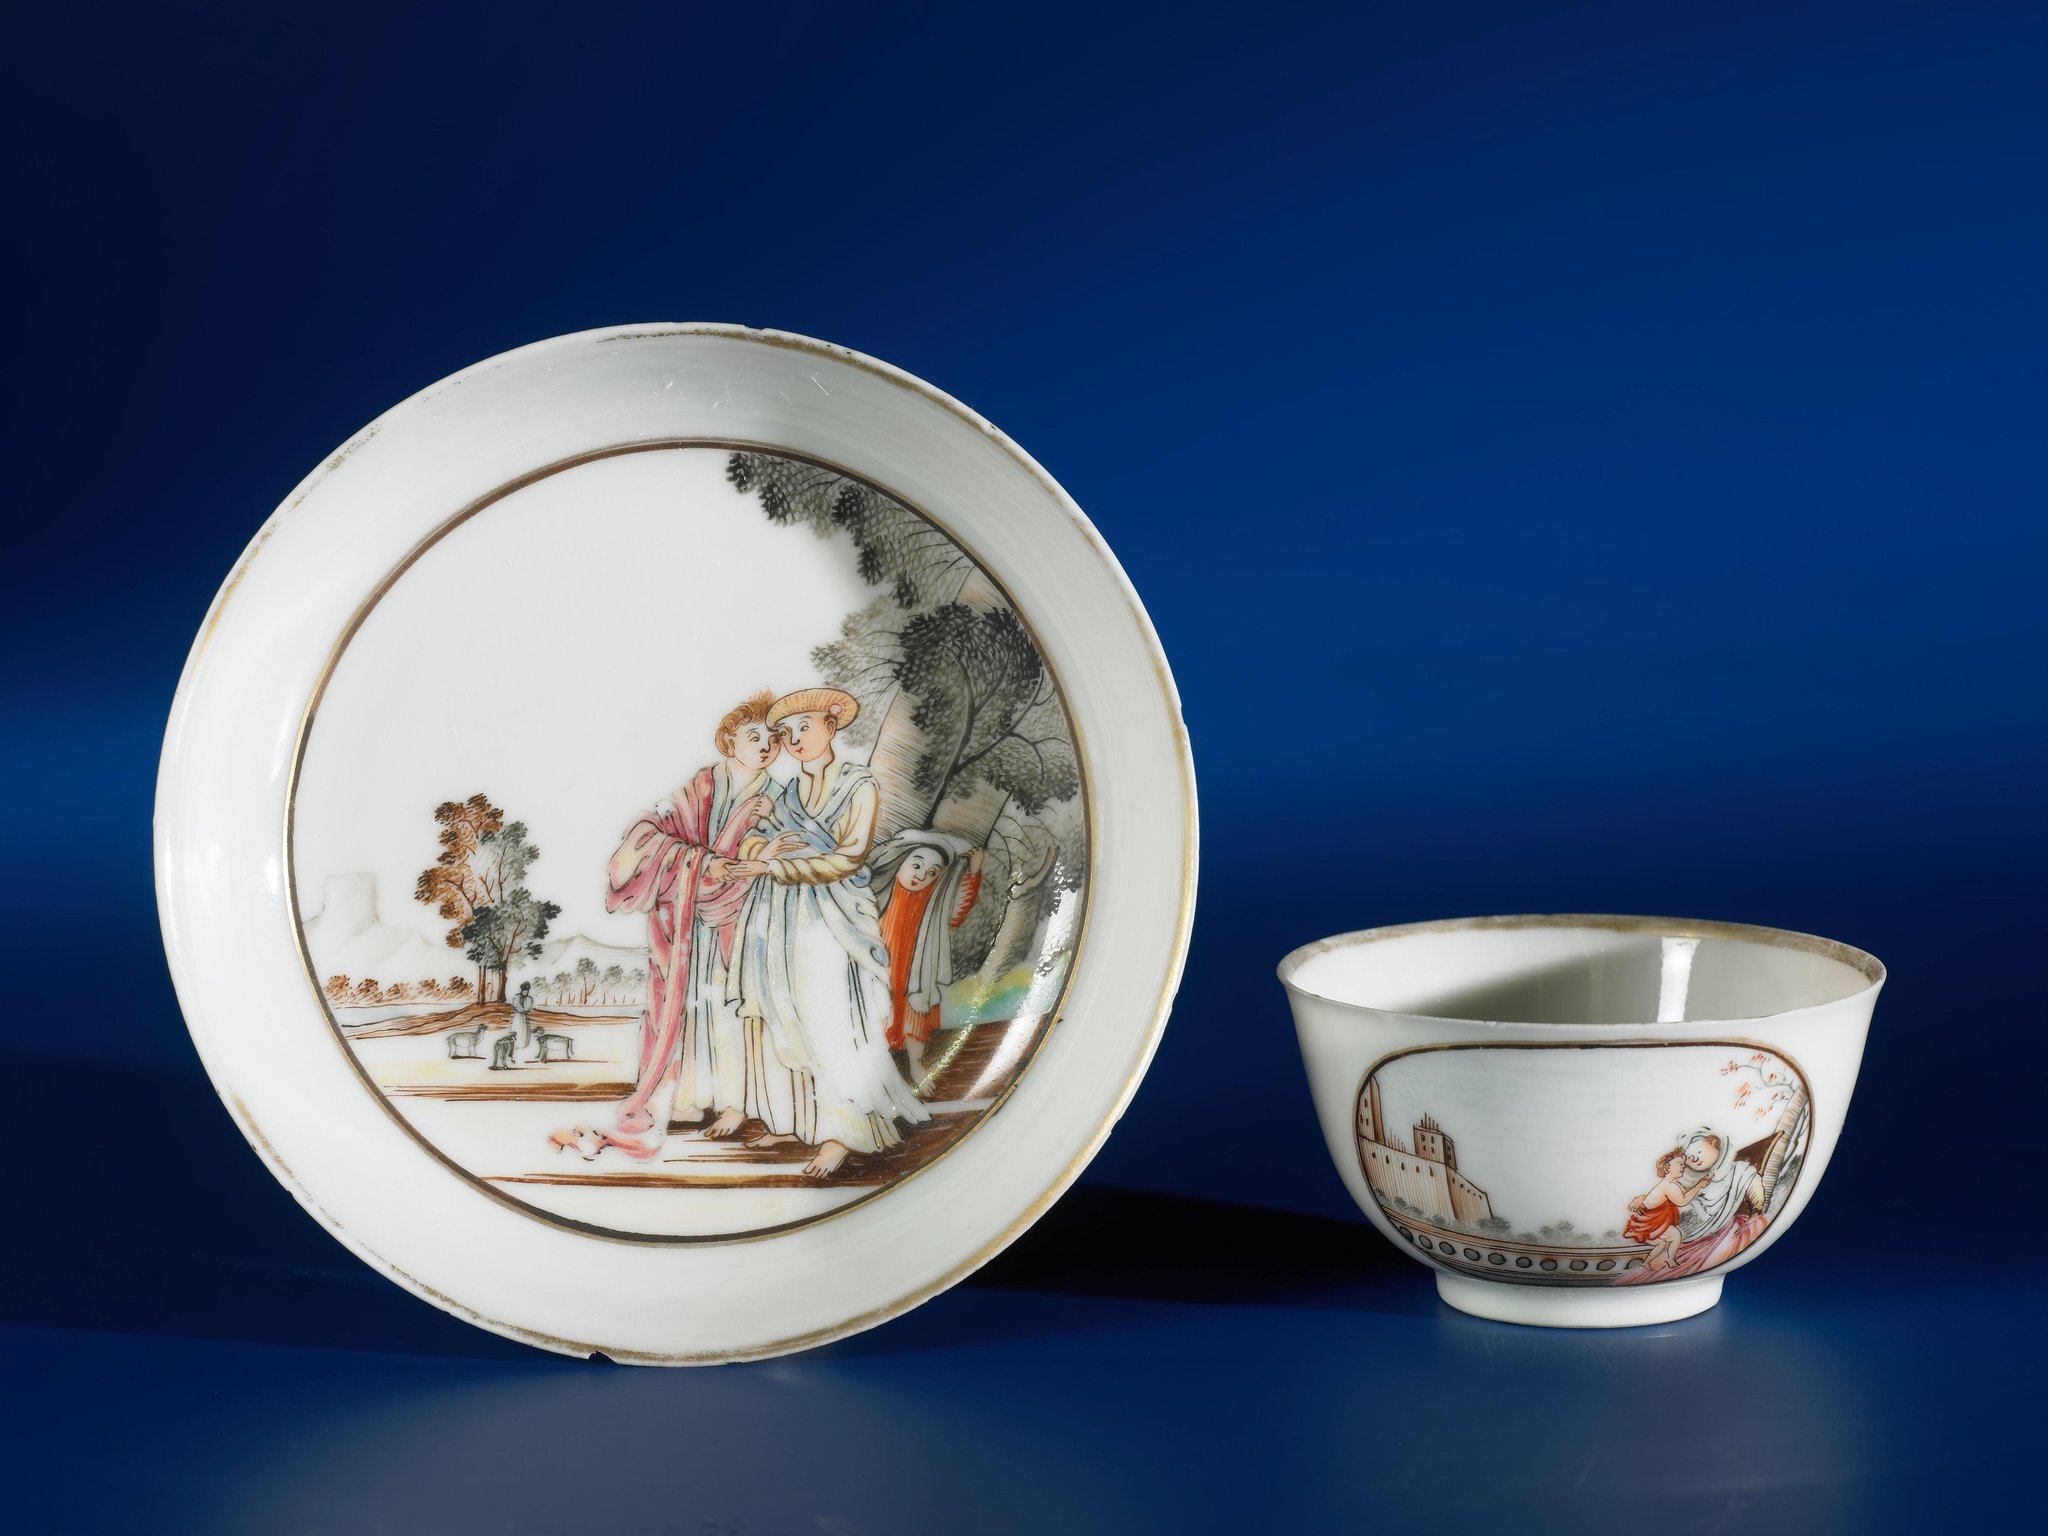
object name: kop en schotel, kop en schotel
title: Bell-shaped cup with European figures in a landscape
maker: Anonymous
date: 1740-1760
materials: glaze, gold, paint, porcelain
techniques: firing, gilding, turning, vitrification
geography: china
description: Wijd uitlopende kop op een hoge voetring en schotel op een voetring. Gedecoreerd in emailkleuren en goud. Op het bord een voorstelling van een verliefd paar in een landschap, gadegeslagen door een derde figuurtje. Op de achtergrond drie schapen en een herder. Op het kopje een voorstelling van een vrouw, zij houdt een kind vast. Op de achtergrond een kasteel.